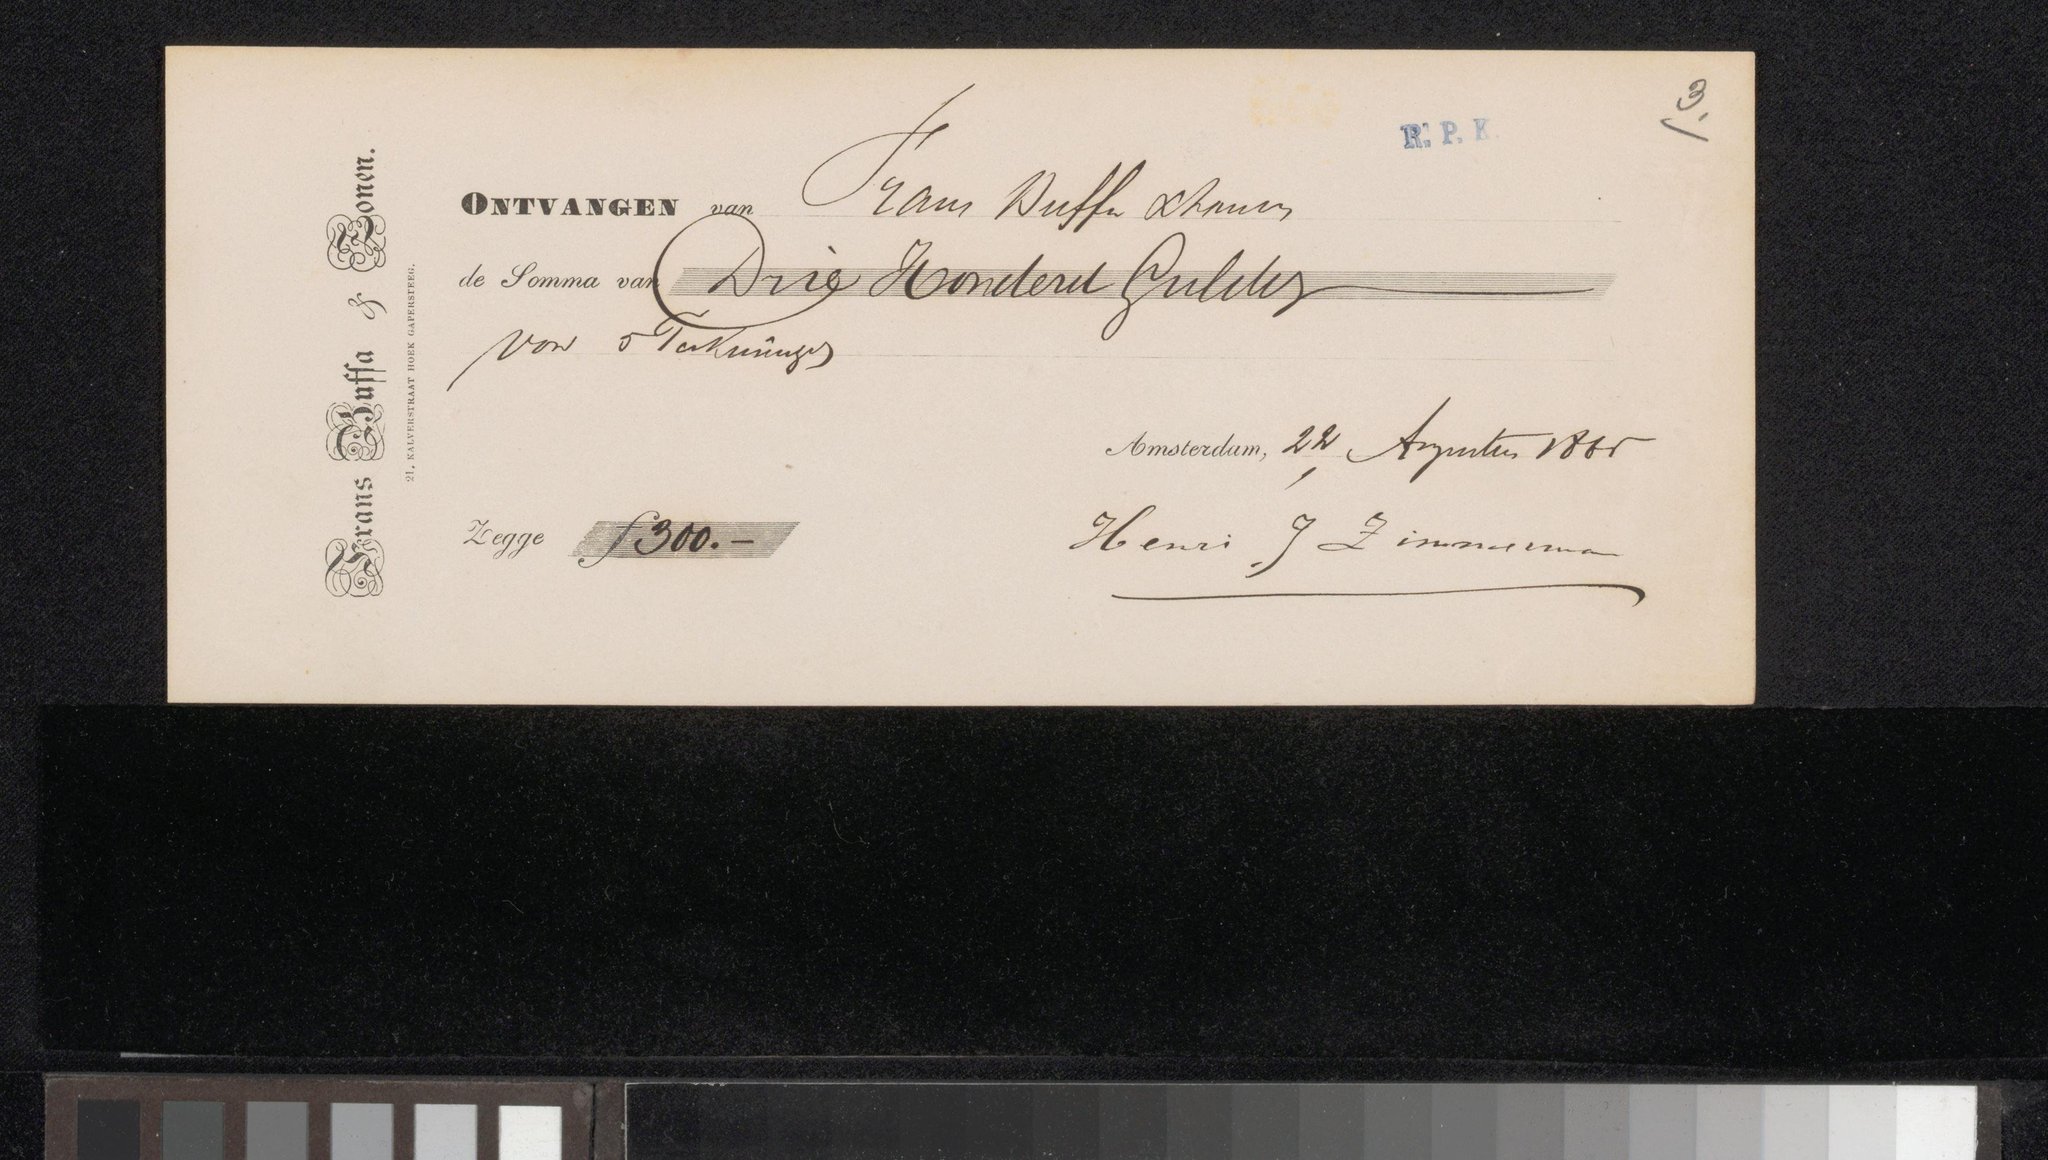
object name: ontvangstbewijs, kwitantie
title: Kwitantie voor Hendrik Jan Zimmerman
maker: hendrik jan zimmerman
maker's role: bookseller, publisher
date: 1865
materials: ink, paper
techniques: pen, printing, writing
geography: amsterdam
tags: drawing, money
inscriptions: collector's mark: Lugt 2233